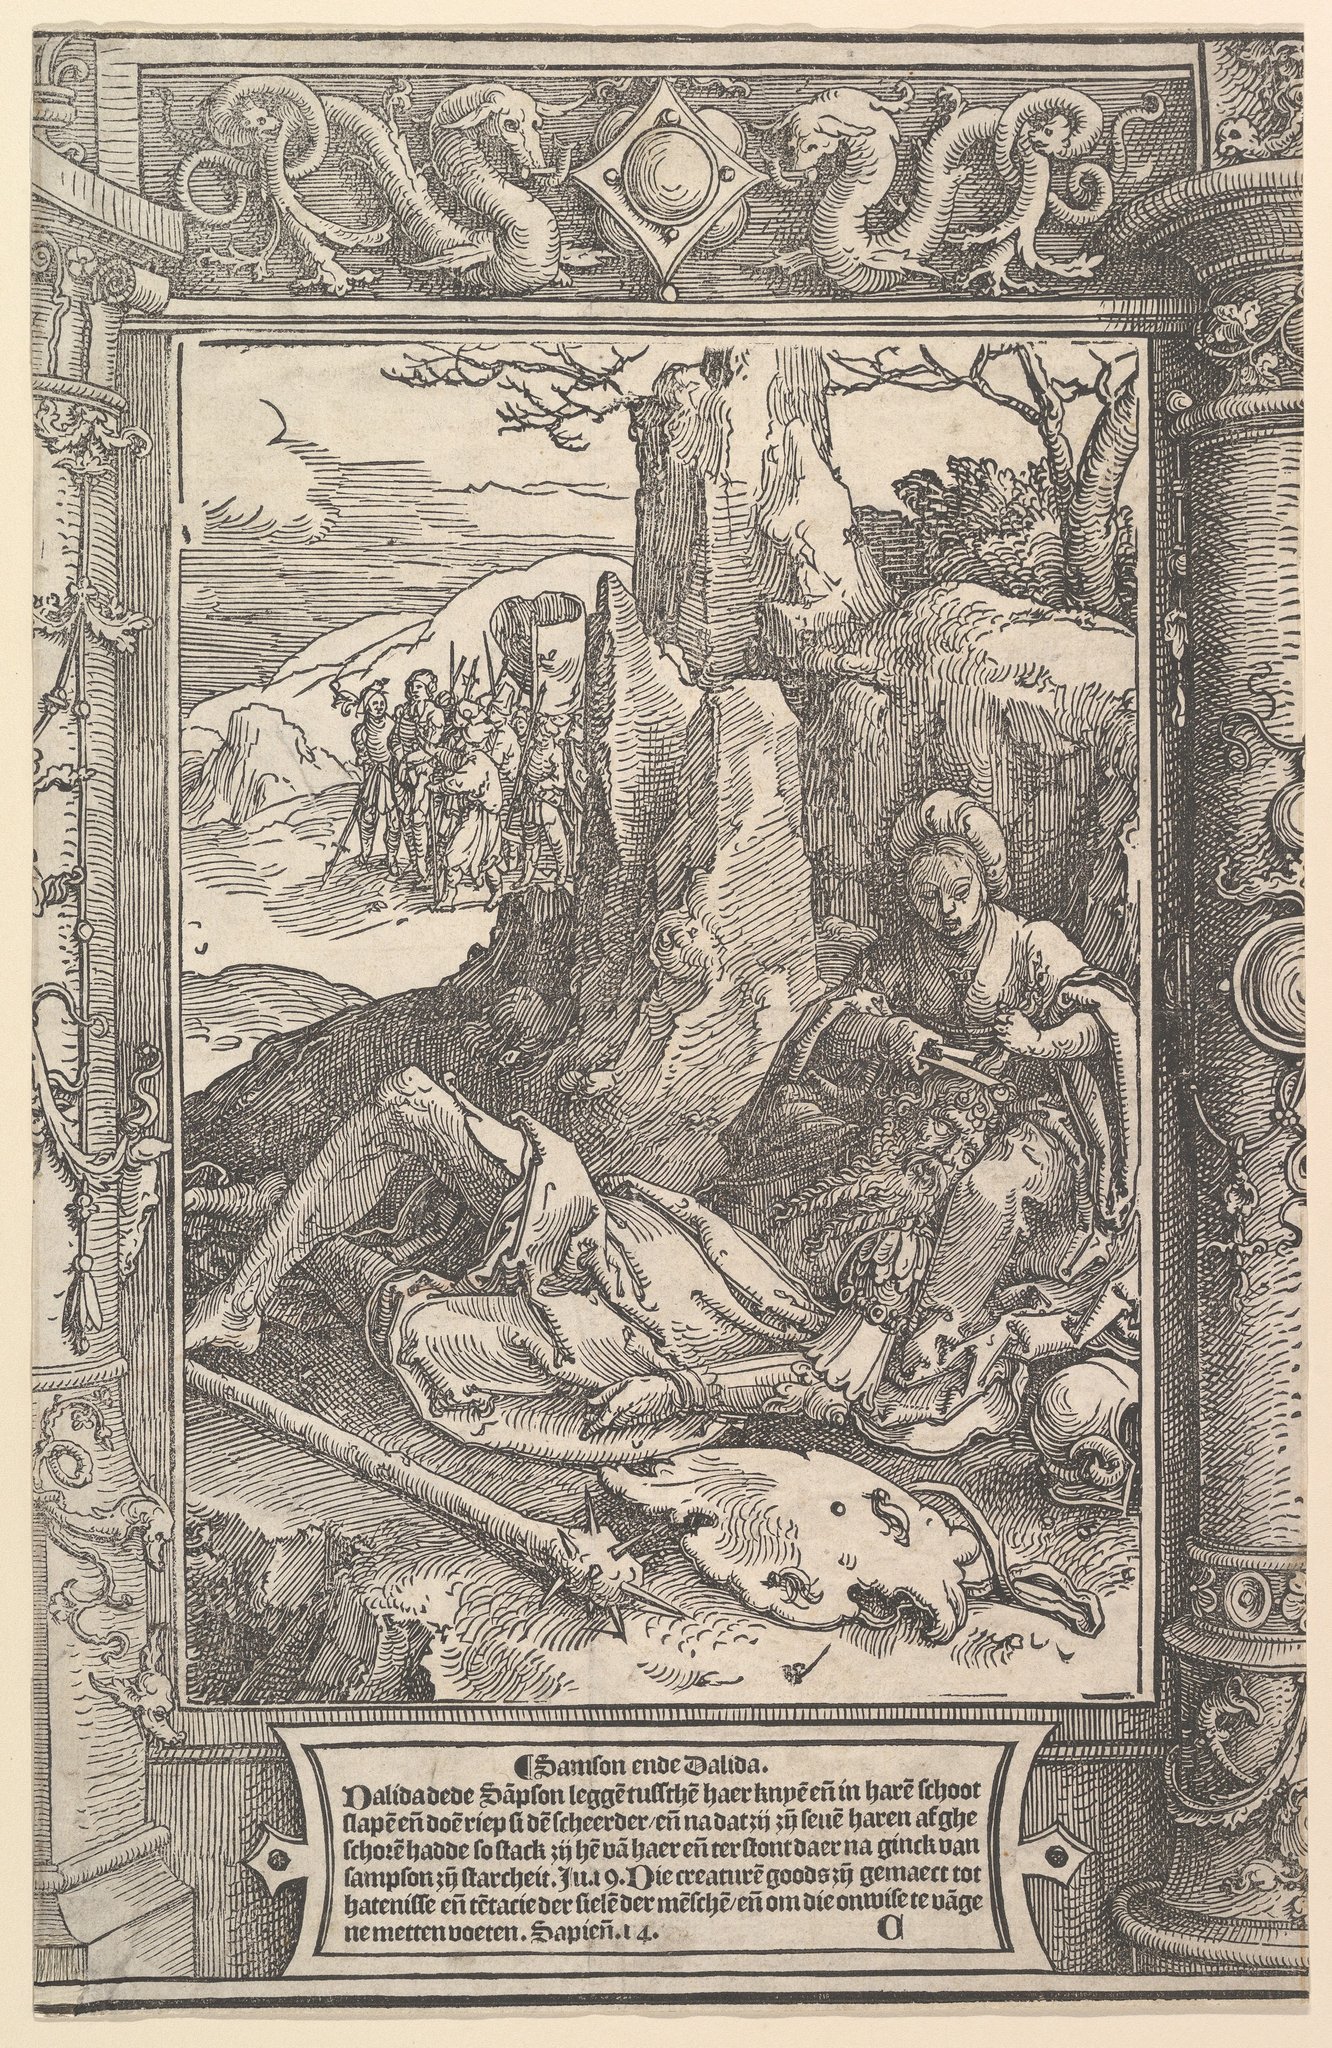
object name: print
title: Samson and Delilah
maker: lucas van leyden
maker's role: artist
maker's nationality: netherlandish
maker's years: 1494-1533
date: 1517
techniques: woodcut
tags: men,women